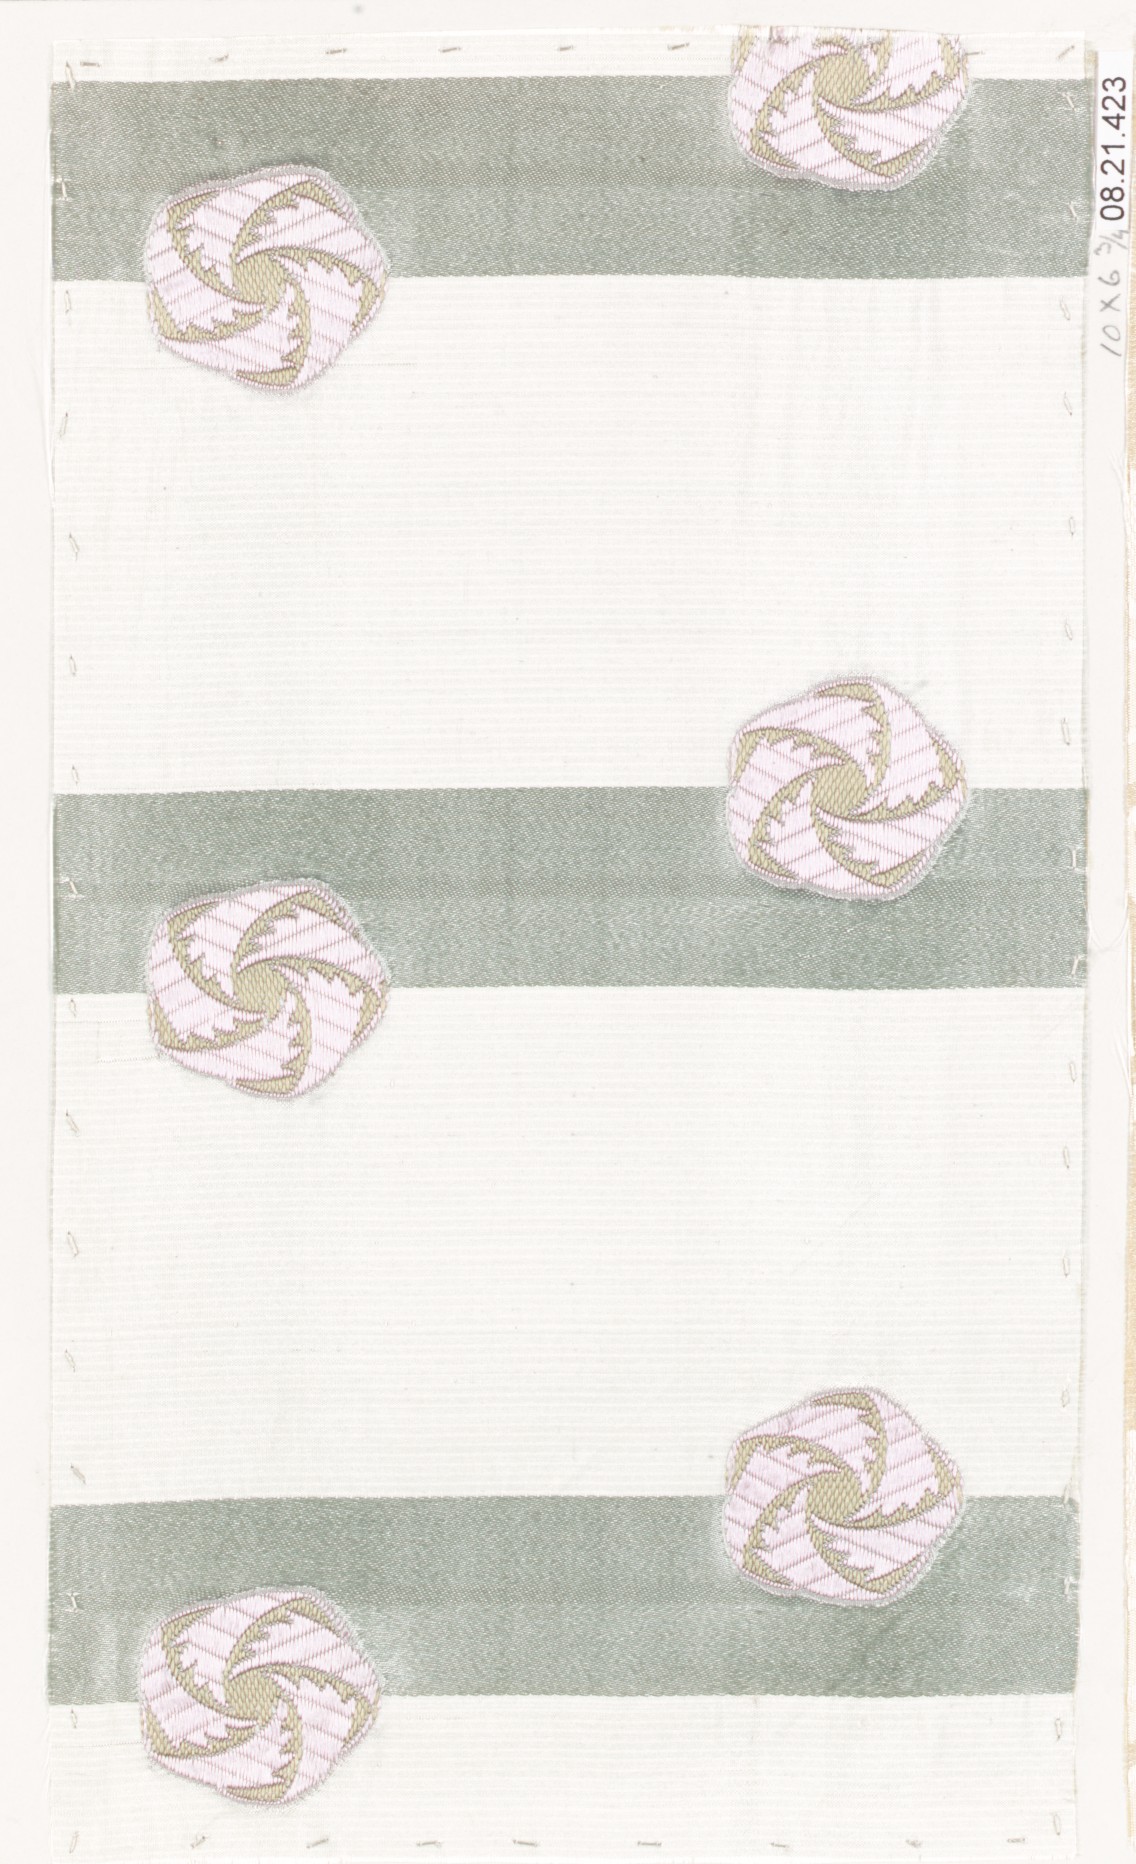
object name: textile sample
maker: Anonymous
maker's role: designer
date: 1900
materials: silk